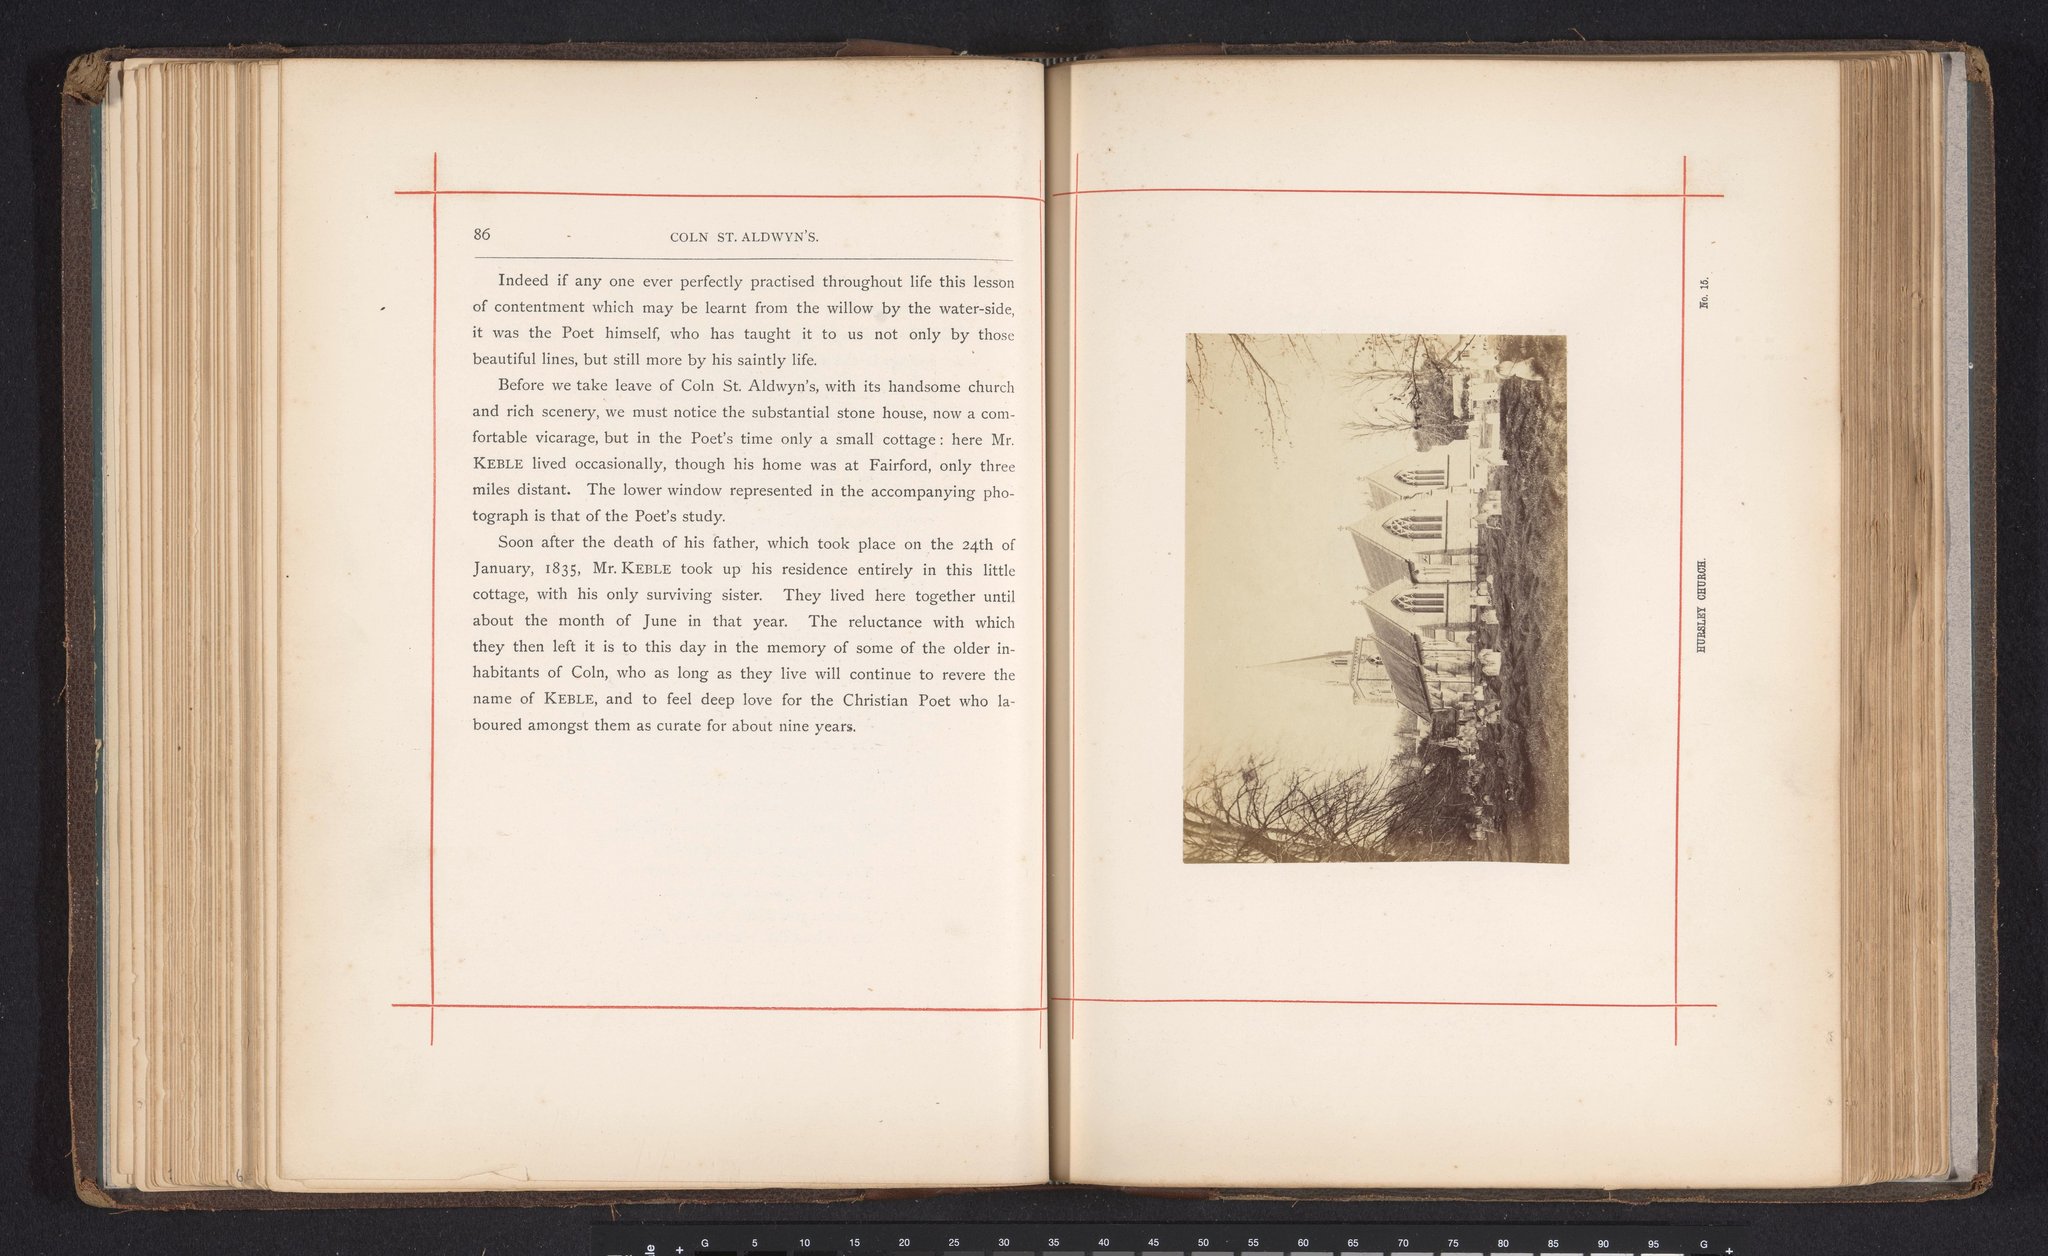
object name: photograph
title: Gezicht op de All Saints' Church in Hursley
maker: william savage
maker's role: fotograaf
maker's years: 1817-1887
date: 1861-1866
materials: paper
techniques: albumen print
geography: hursley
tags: church (exterior)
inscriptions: number: ‘No. 15.’